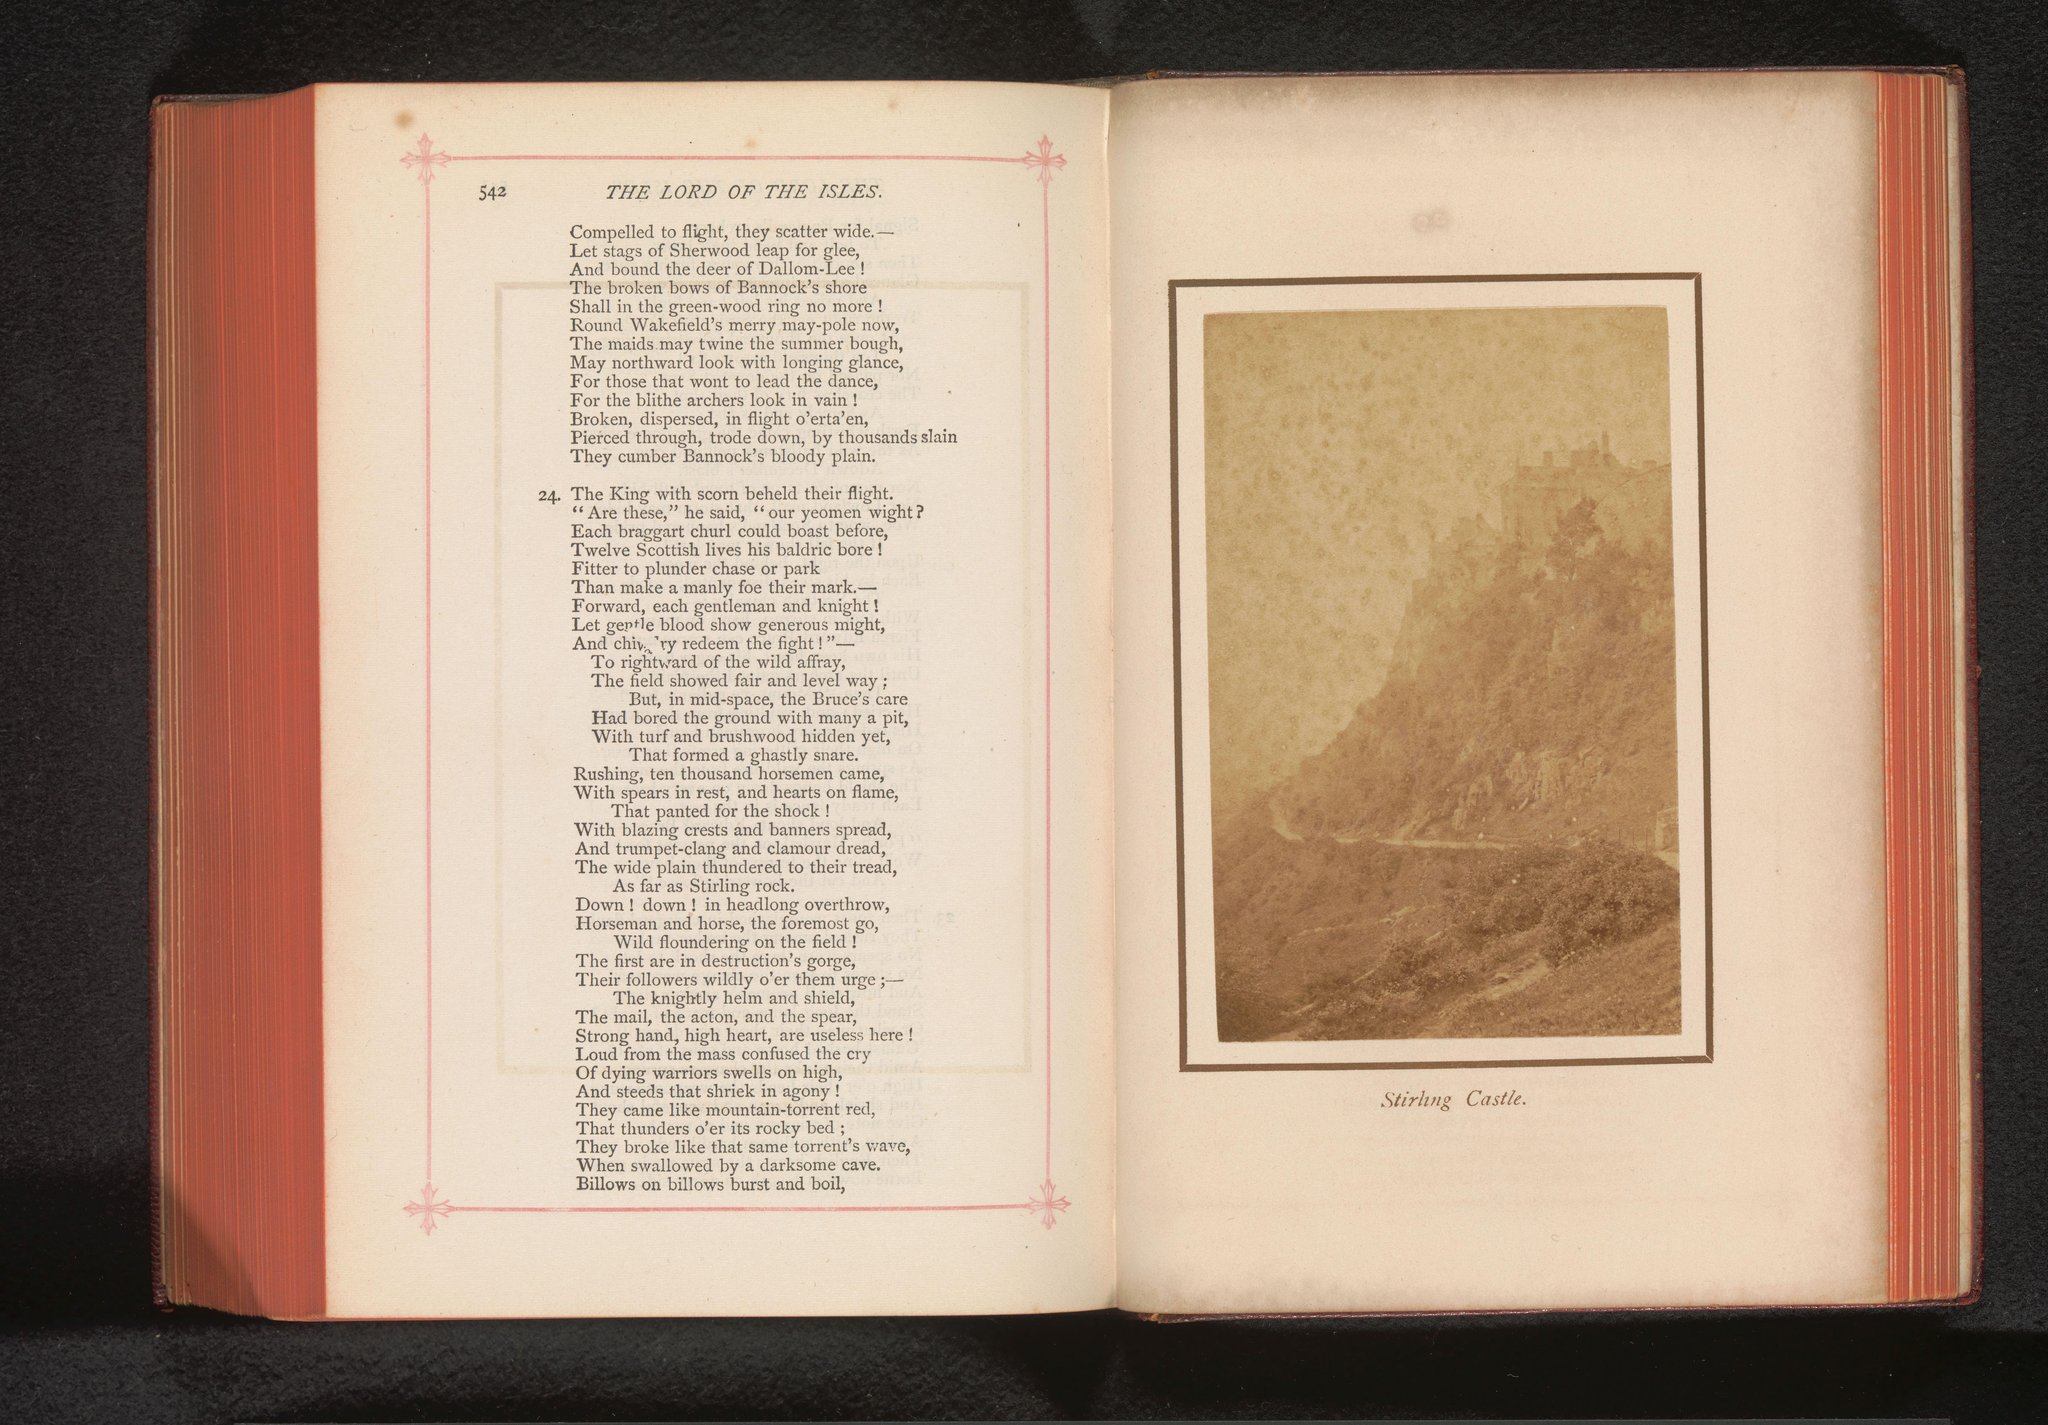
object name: photograph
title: Stirling Castle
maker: george washington wilson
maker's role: publisher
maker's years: 1823-1893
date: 1885-1890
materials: photographic support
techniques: albumen print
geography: stirling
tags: castle, façade (of house or building)